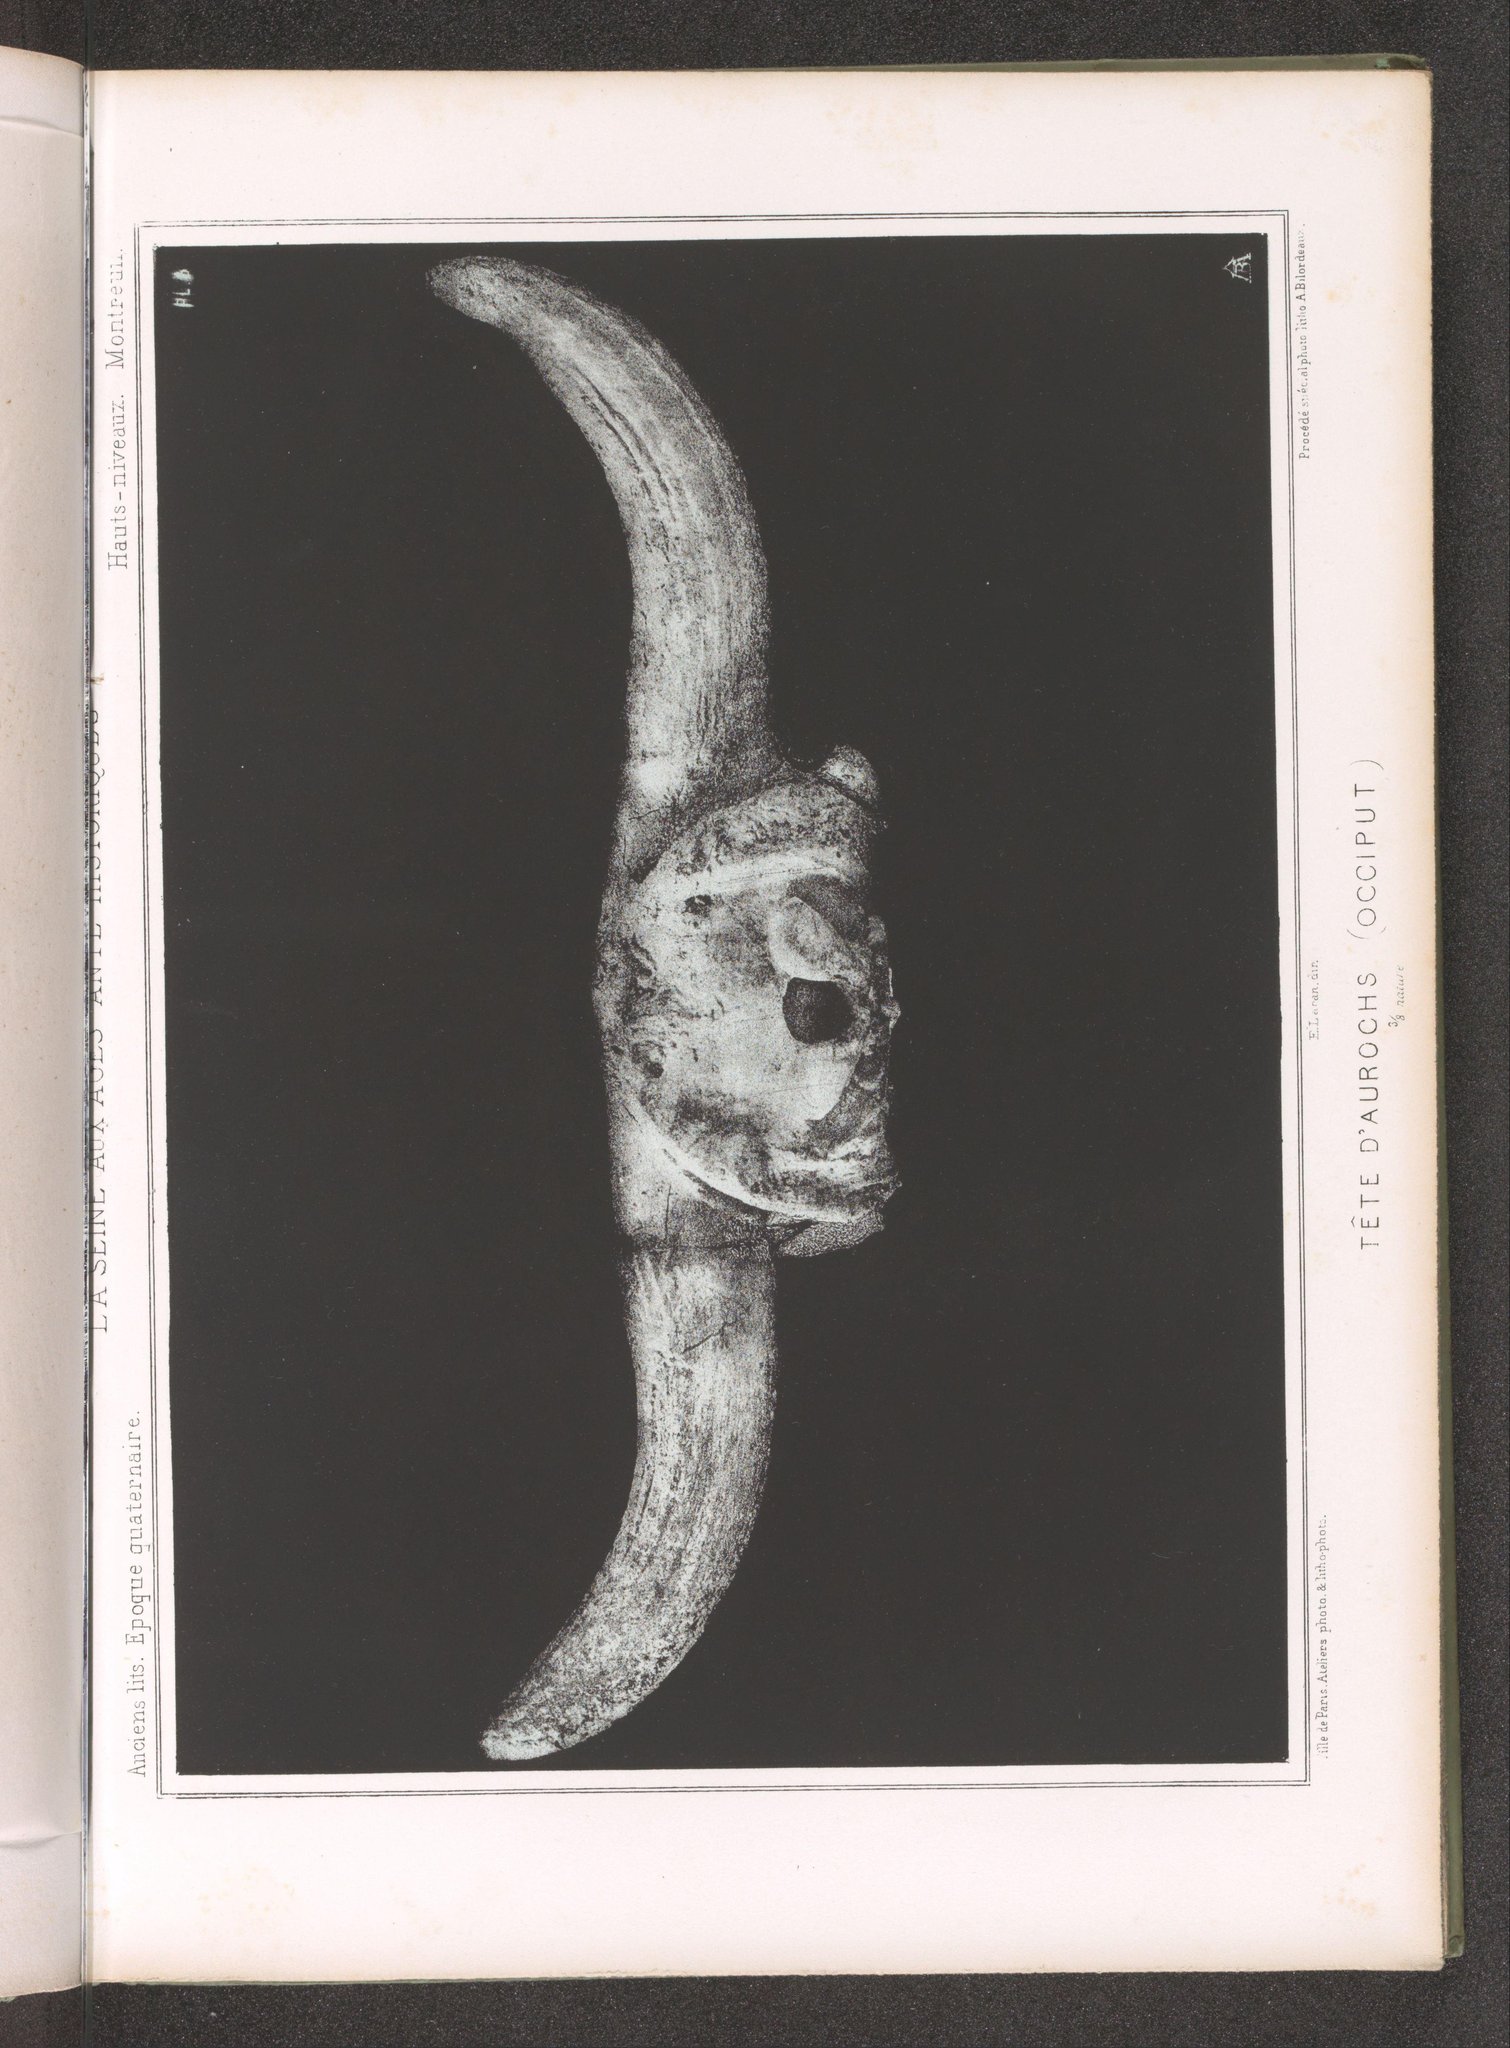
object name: page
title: Schedel van een oeros, achterhoofd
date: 1860-1869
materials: paper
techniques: photolithography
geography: france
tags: animals (+ skeleton of an animal), palaeontology, france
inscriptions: inscription: ‘Ville de Paris Ateliers photo & litho photo E. Lacan, dir. Procédé spécial photo-litho A. Bilordeaux’, number: ‘Pl. 3’, monogram: ‘AB’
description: Voor plek prent in boek: zie nummer onder 'Opschriften / Merken'.